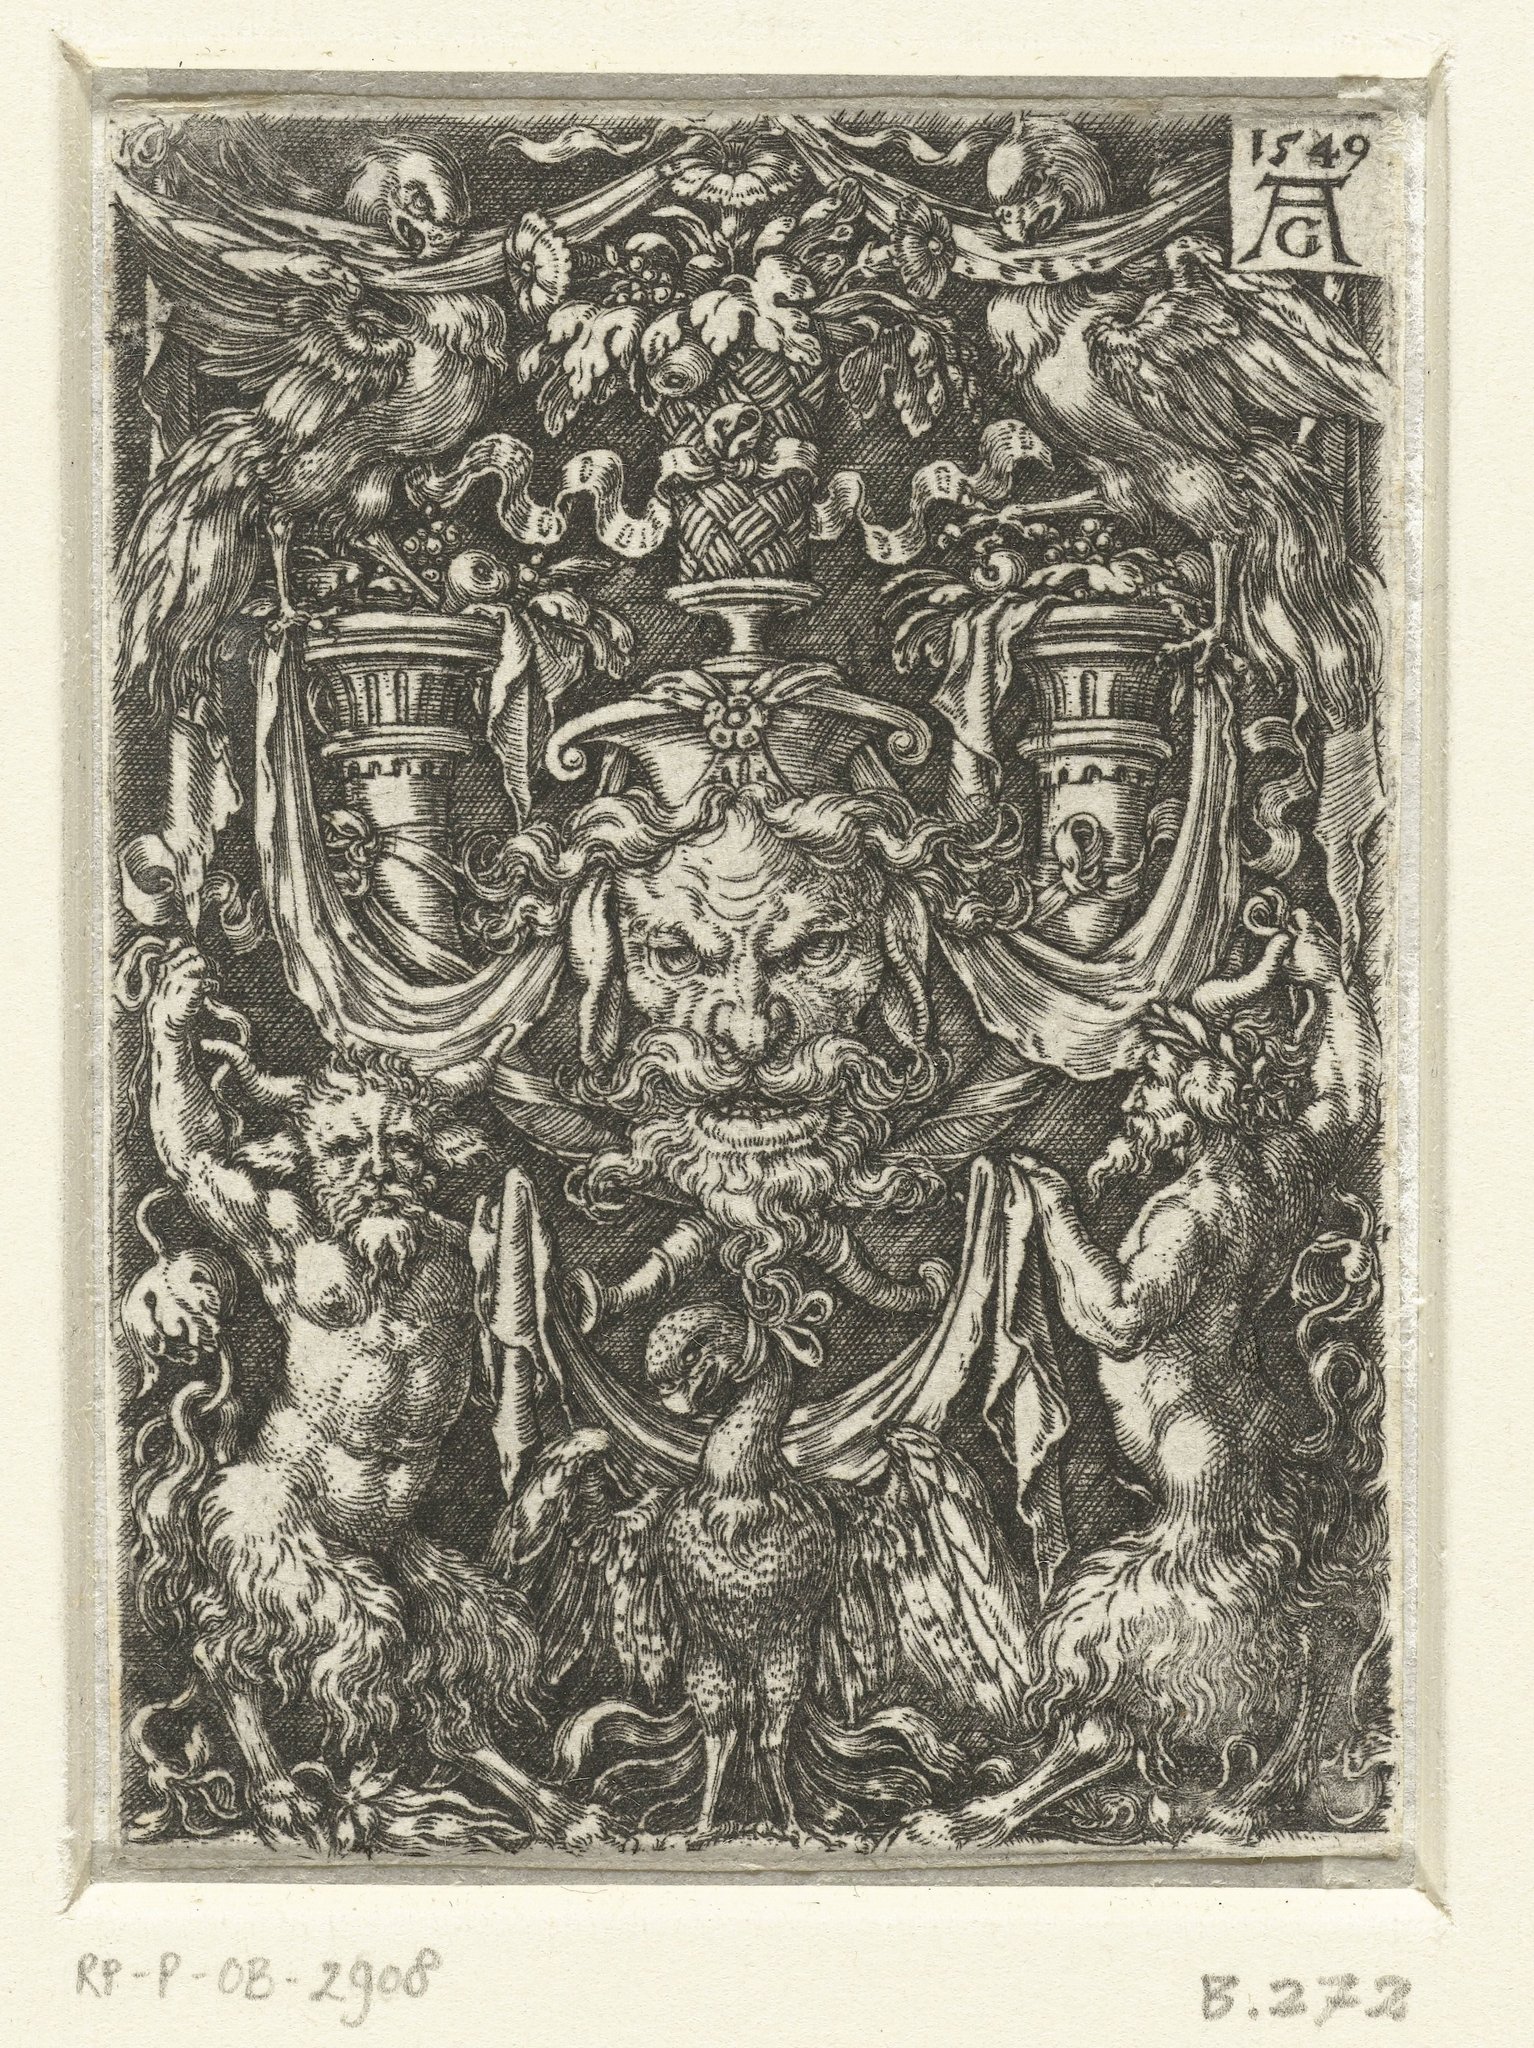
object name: ornament print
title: Vlakdecoratie met grotesken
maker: heinrich aldegrever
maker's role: draughtsman, print maker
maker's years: 1502-1561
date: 1549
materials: paper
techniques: engraving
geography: germany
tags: ornaments ~ art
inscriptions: number: ‘23’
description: Vlakdecoratie met een masker tussen twee hoorns des overvloeds waarop vogels zitten. Onder het masker een vogel met aan weerszijden een sater.